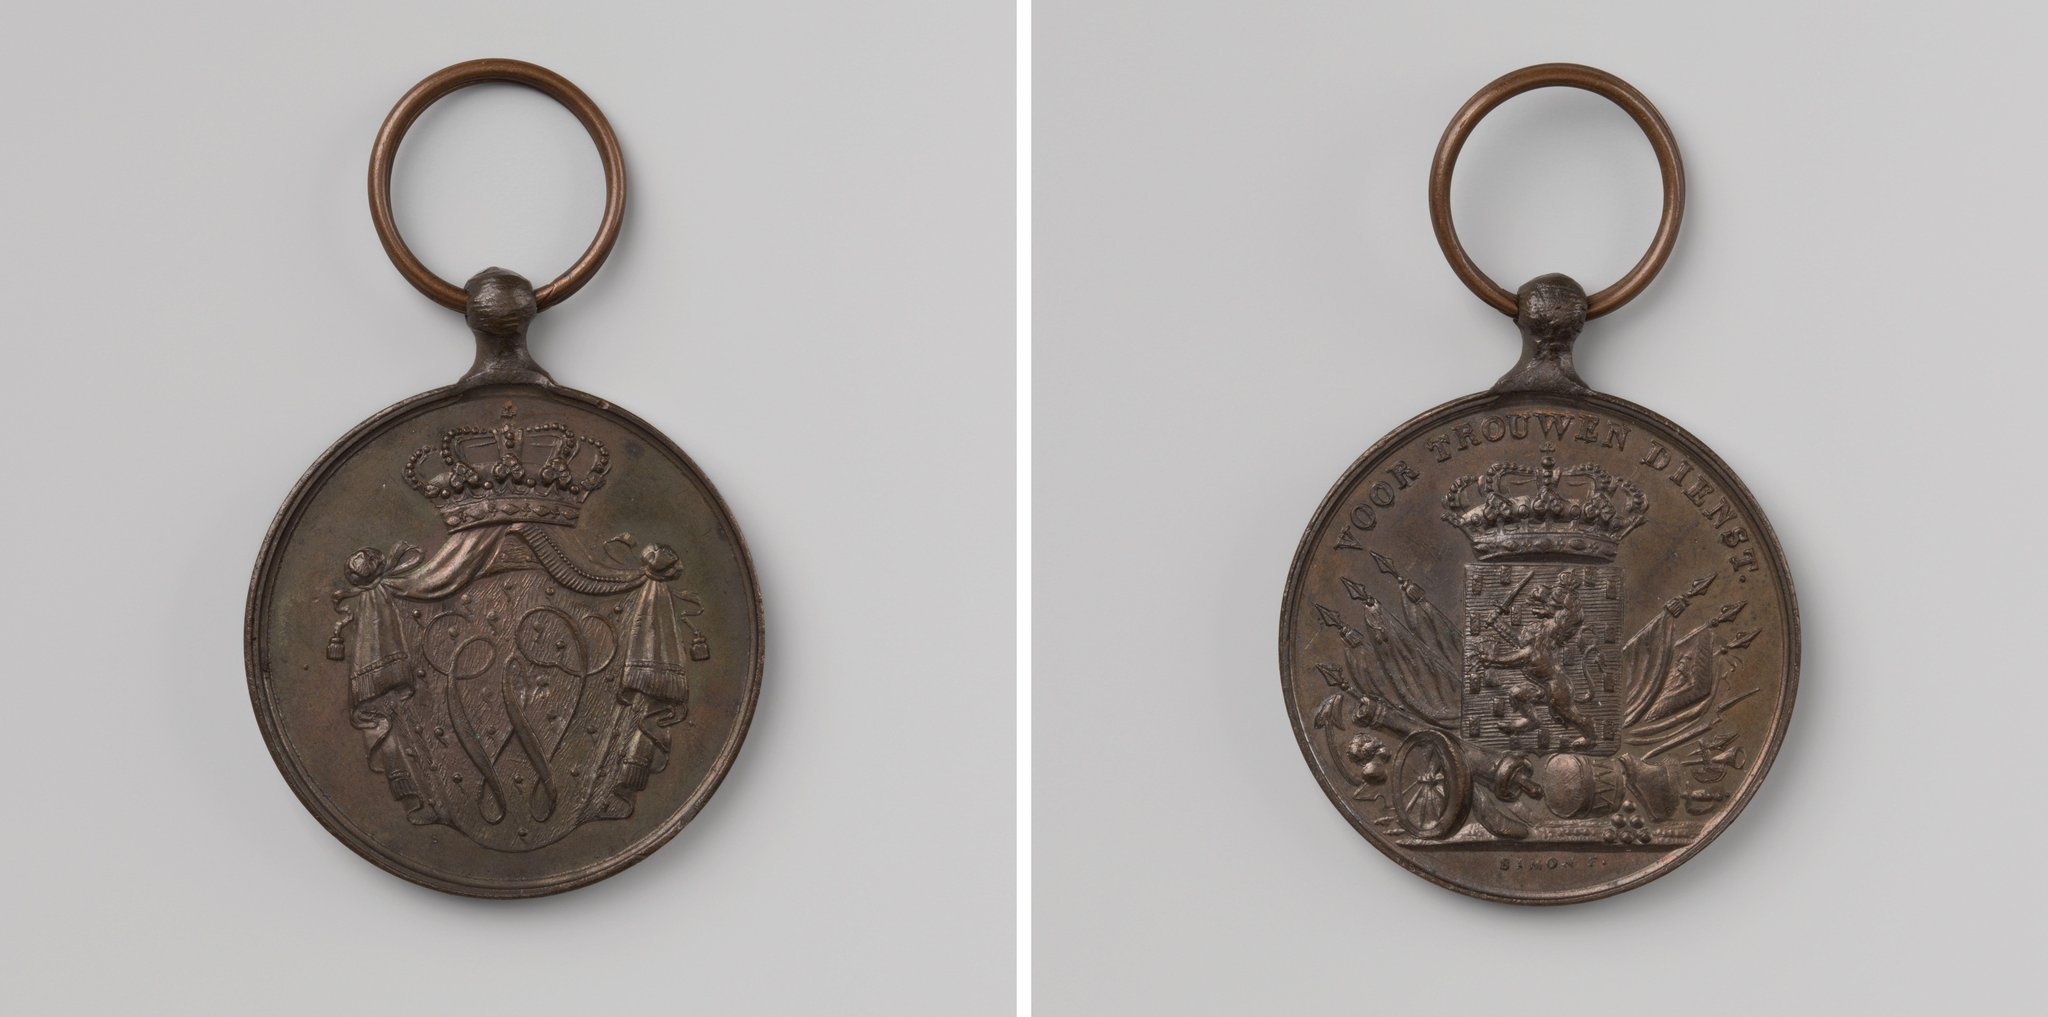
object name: insignia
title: Trouwen dienst bij de landmacht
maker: jean henri simon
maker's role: medailleur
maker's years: 1752-1834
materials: bronze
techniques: striking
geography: brussels